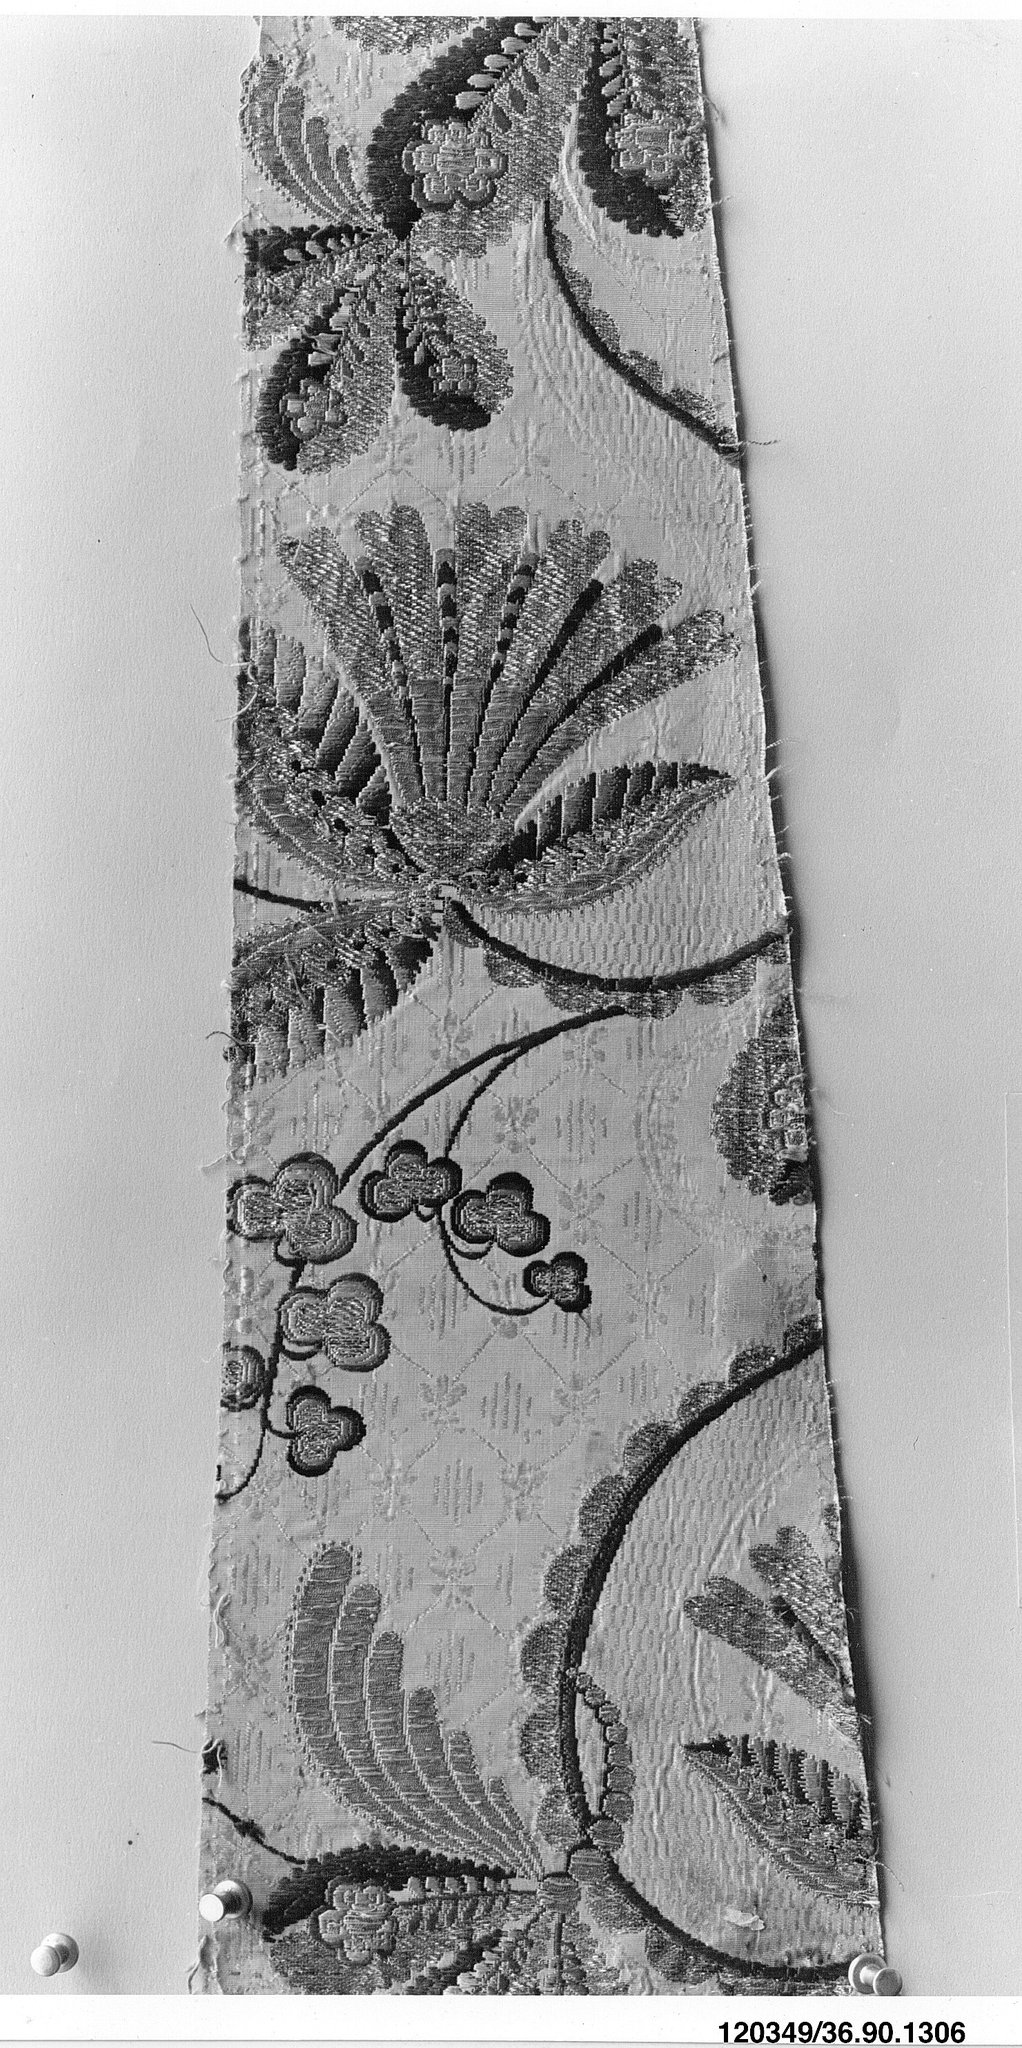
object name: piece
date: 1701-1800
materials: metal thread, silk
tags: flowers,leaves